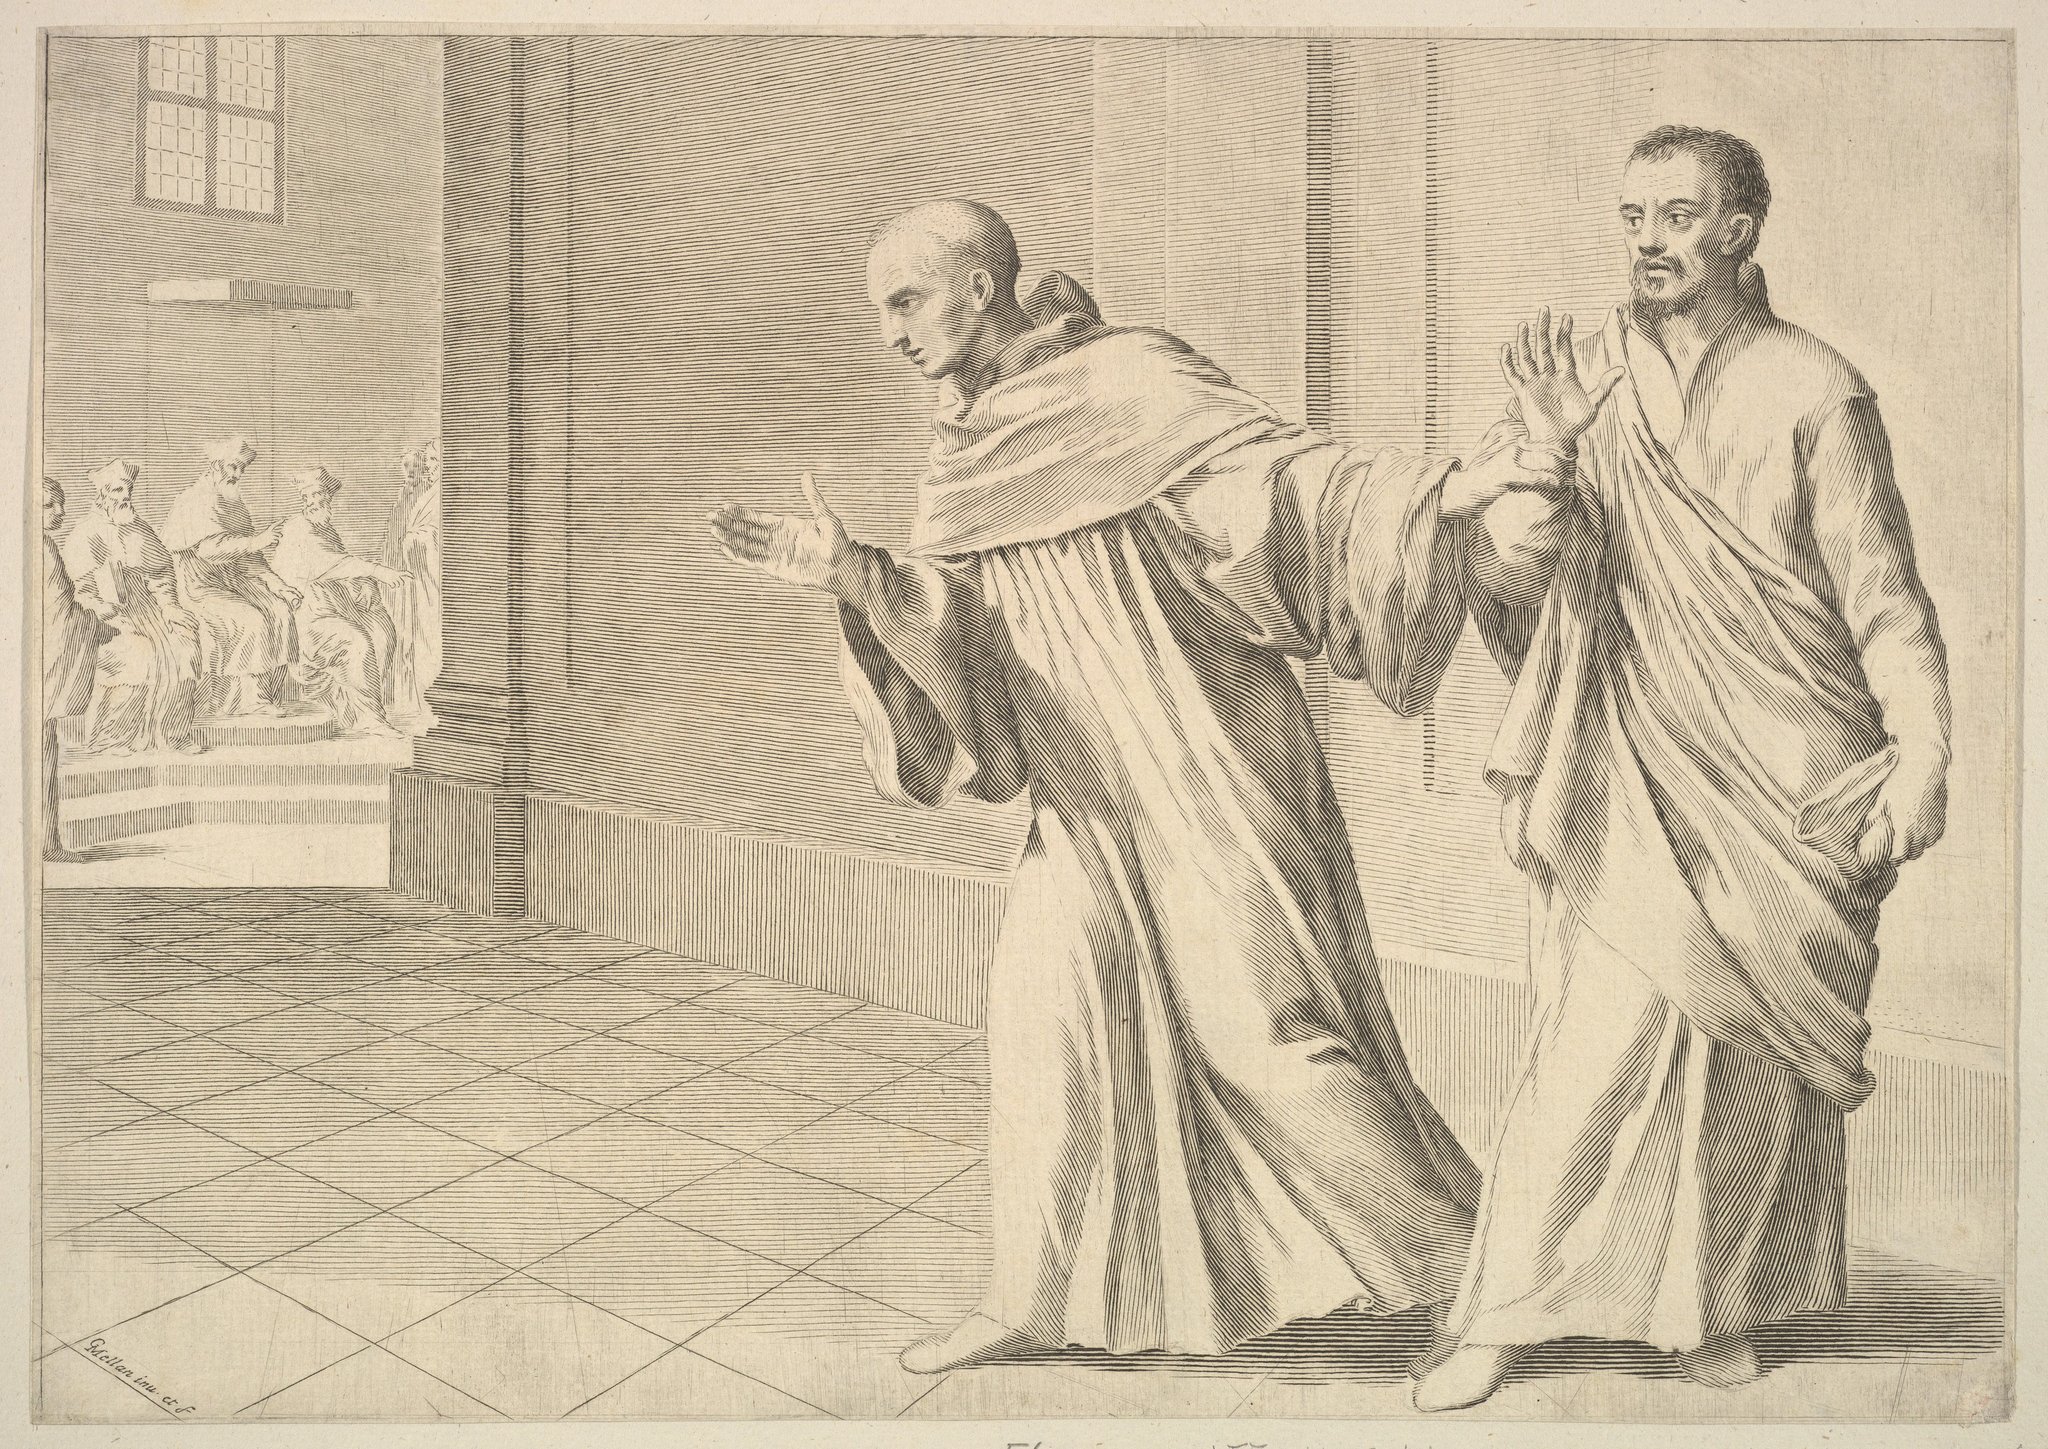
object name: print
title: St. Bernard Taking a Brother to an Assembly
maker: claude mellan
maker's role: artist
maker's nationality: french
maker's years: 1598-1688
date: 1600-1688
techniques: engraving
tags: men,saints